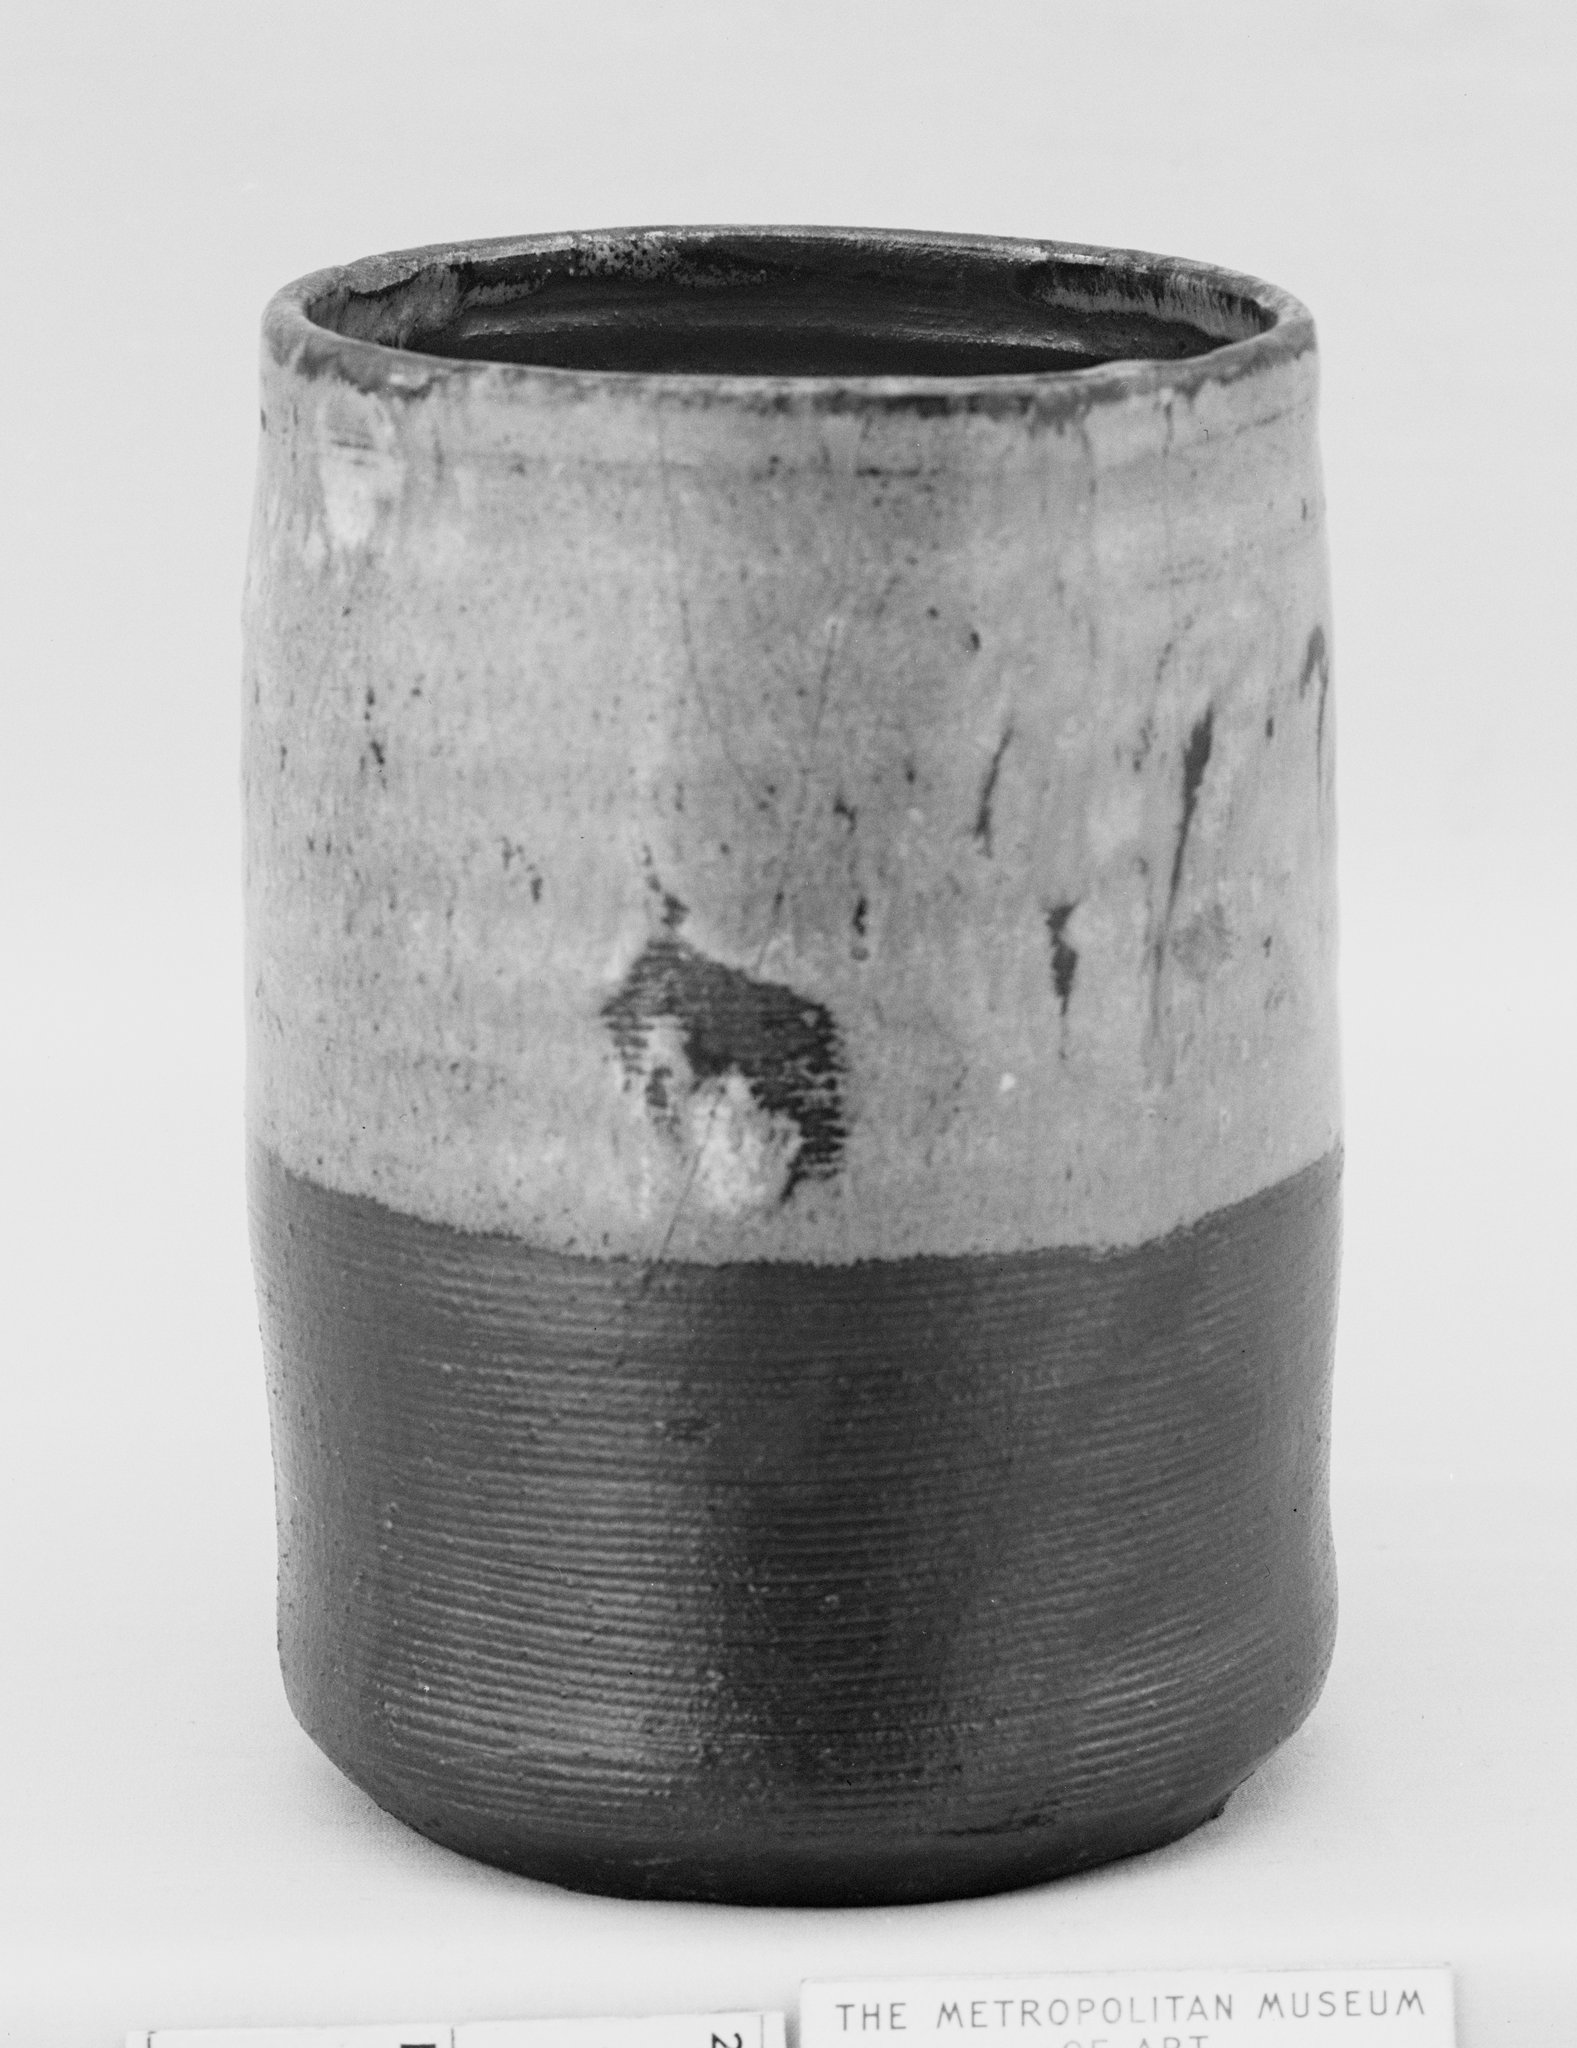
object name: cup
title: Deep Cup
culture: japanese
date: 1801-1900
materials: clay, glaze